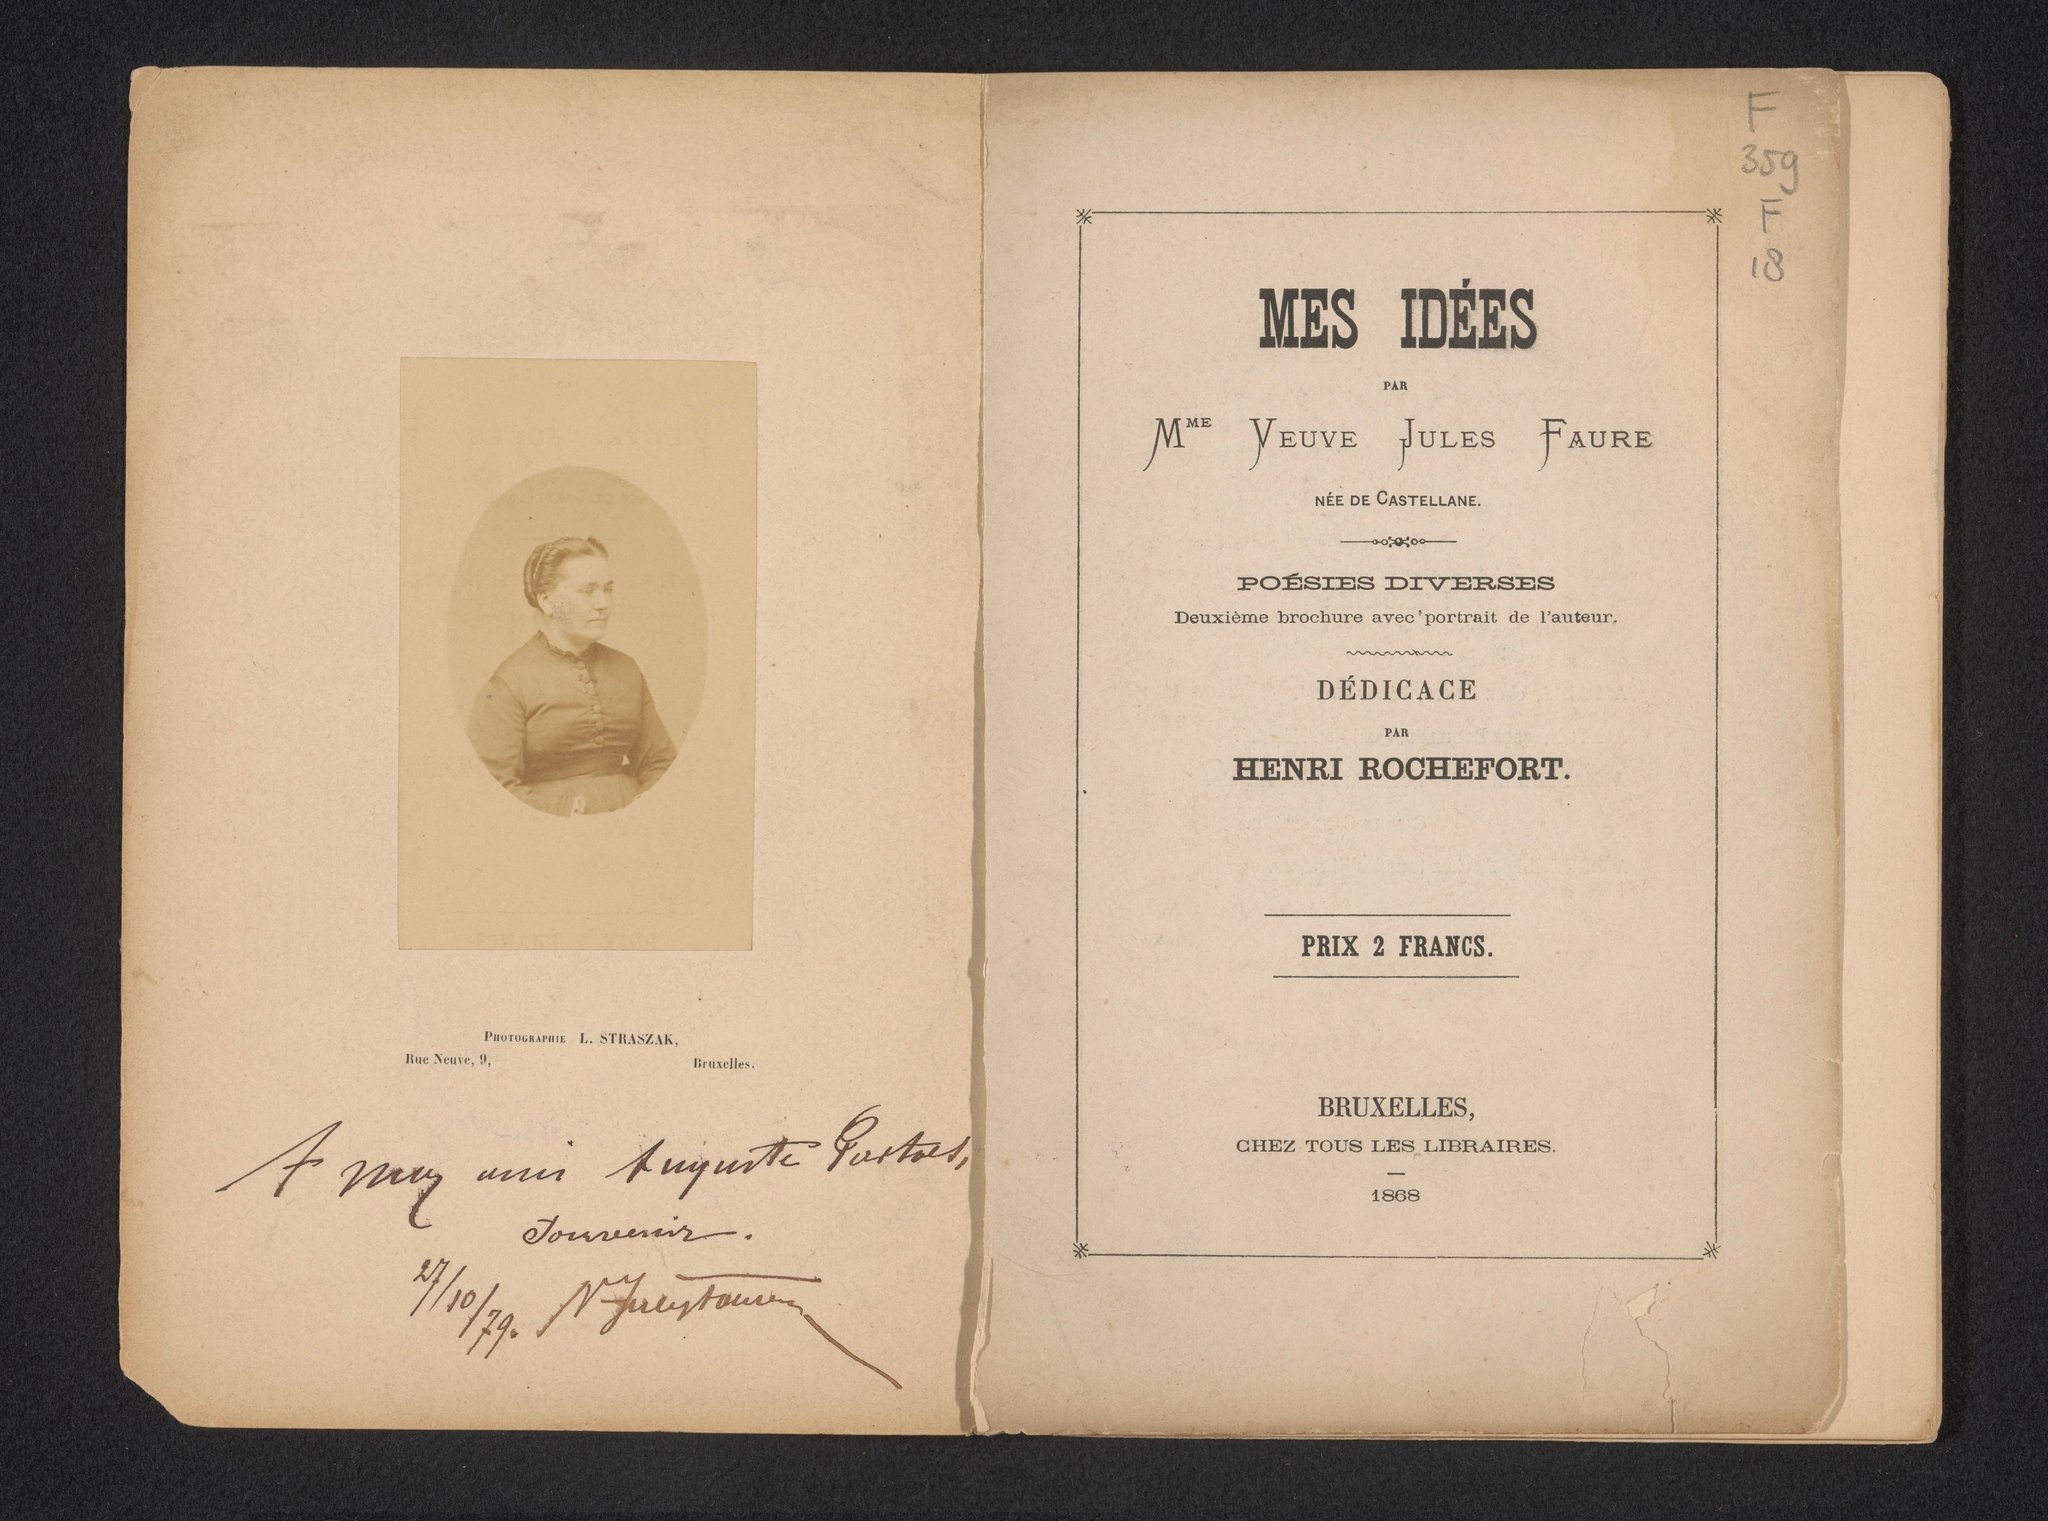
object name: page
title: Portret van Madame Veuve Jules Faure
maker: ladislas straszak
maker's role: fotograaf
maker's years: 1826-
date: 1863-1868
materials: photographic support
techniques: albumen print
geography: brussels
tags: veuve jules faure, historical persons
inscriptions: address: ‘Photographie L. Straszak/ Rue Neuve, 9, Bruxelles.’, annotation: ‘A mon ami Auguste Pastois,/ souvenir./ 27/10/79. V Jules Faure’